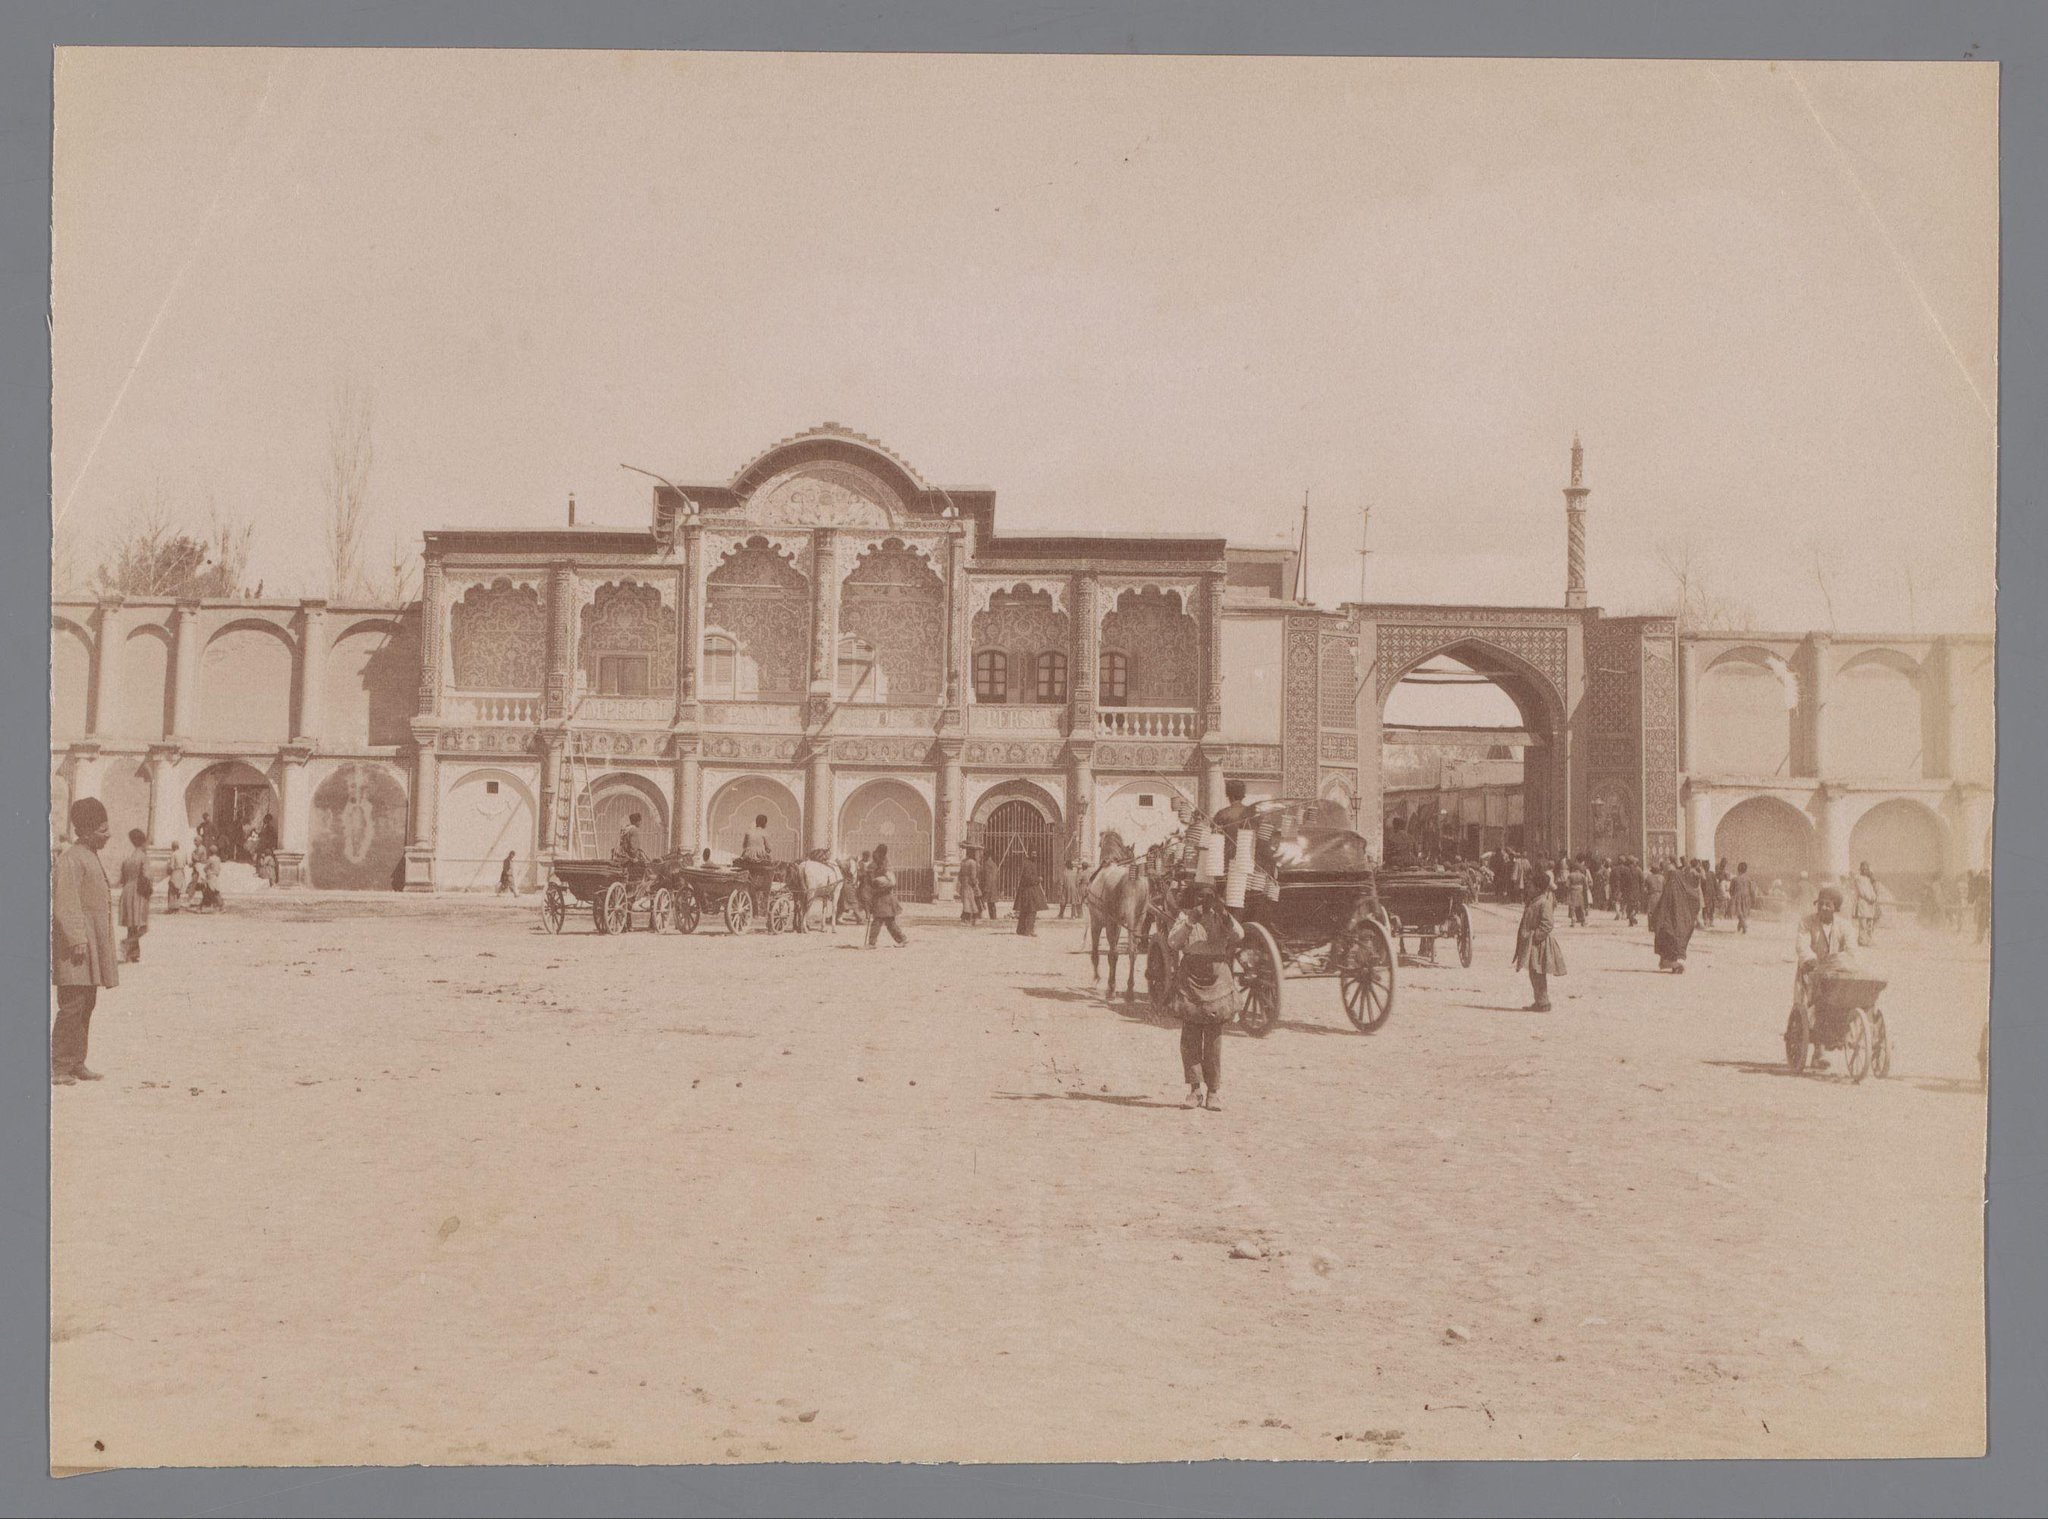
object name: photograph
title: Koninklijke Bank, gebouw, Teheran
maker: antoine sevruguin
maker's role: fotograaf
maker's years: 1840-1933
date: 1880-1910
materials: paper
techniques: albumen print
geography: iran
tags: teheran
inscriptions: inscription: ‘1644//Imp. Banque a Pisse [?] a Teheran’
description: Gezicht op een fraai versierd gebouw aan een plein met mensen en koetsen.